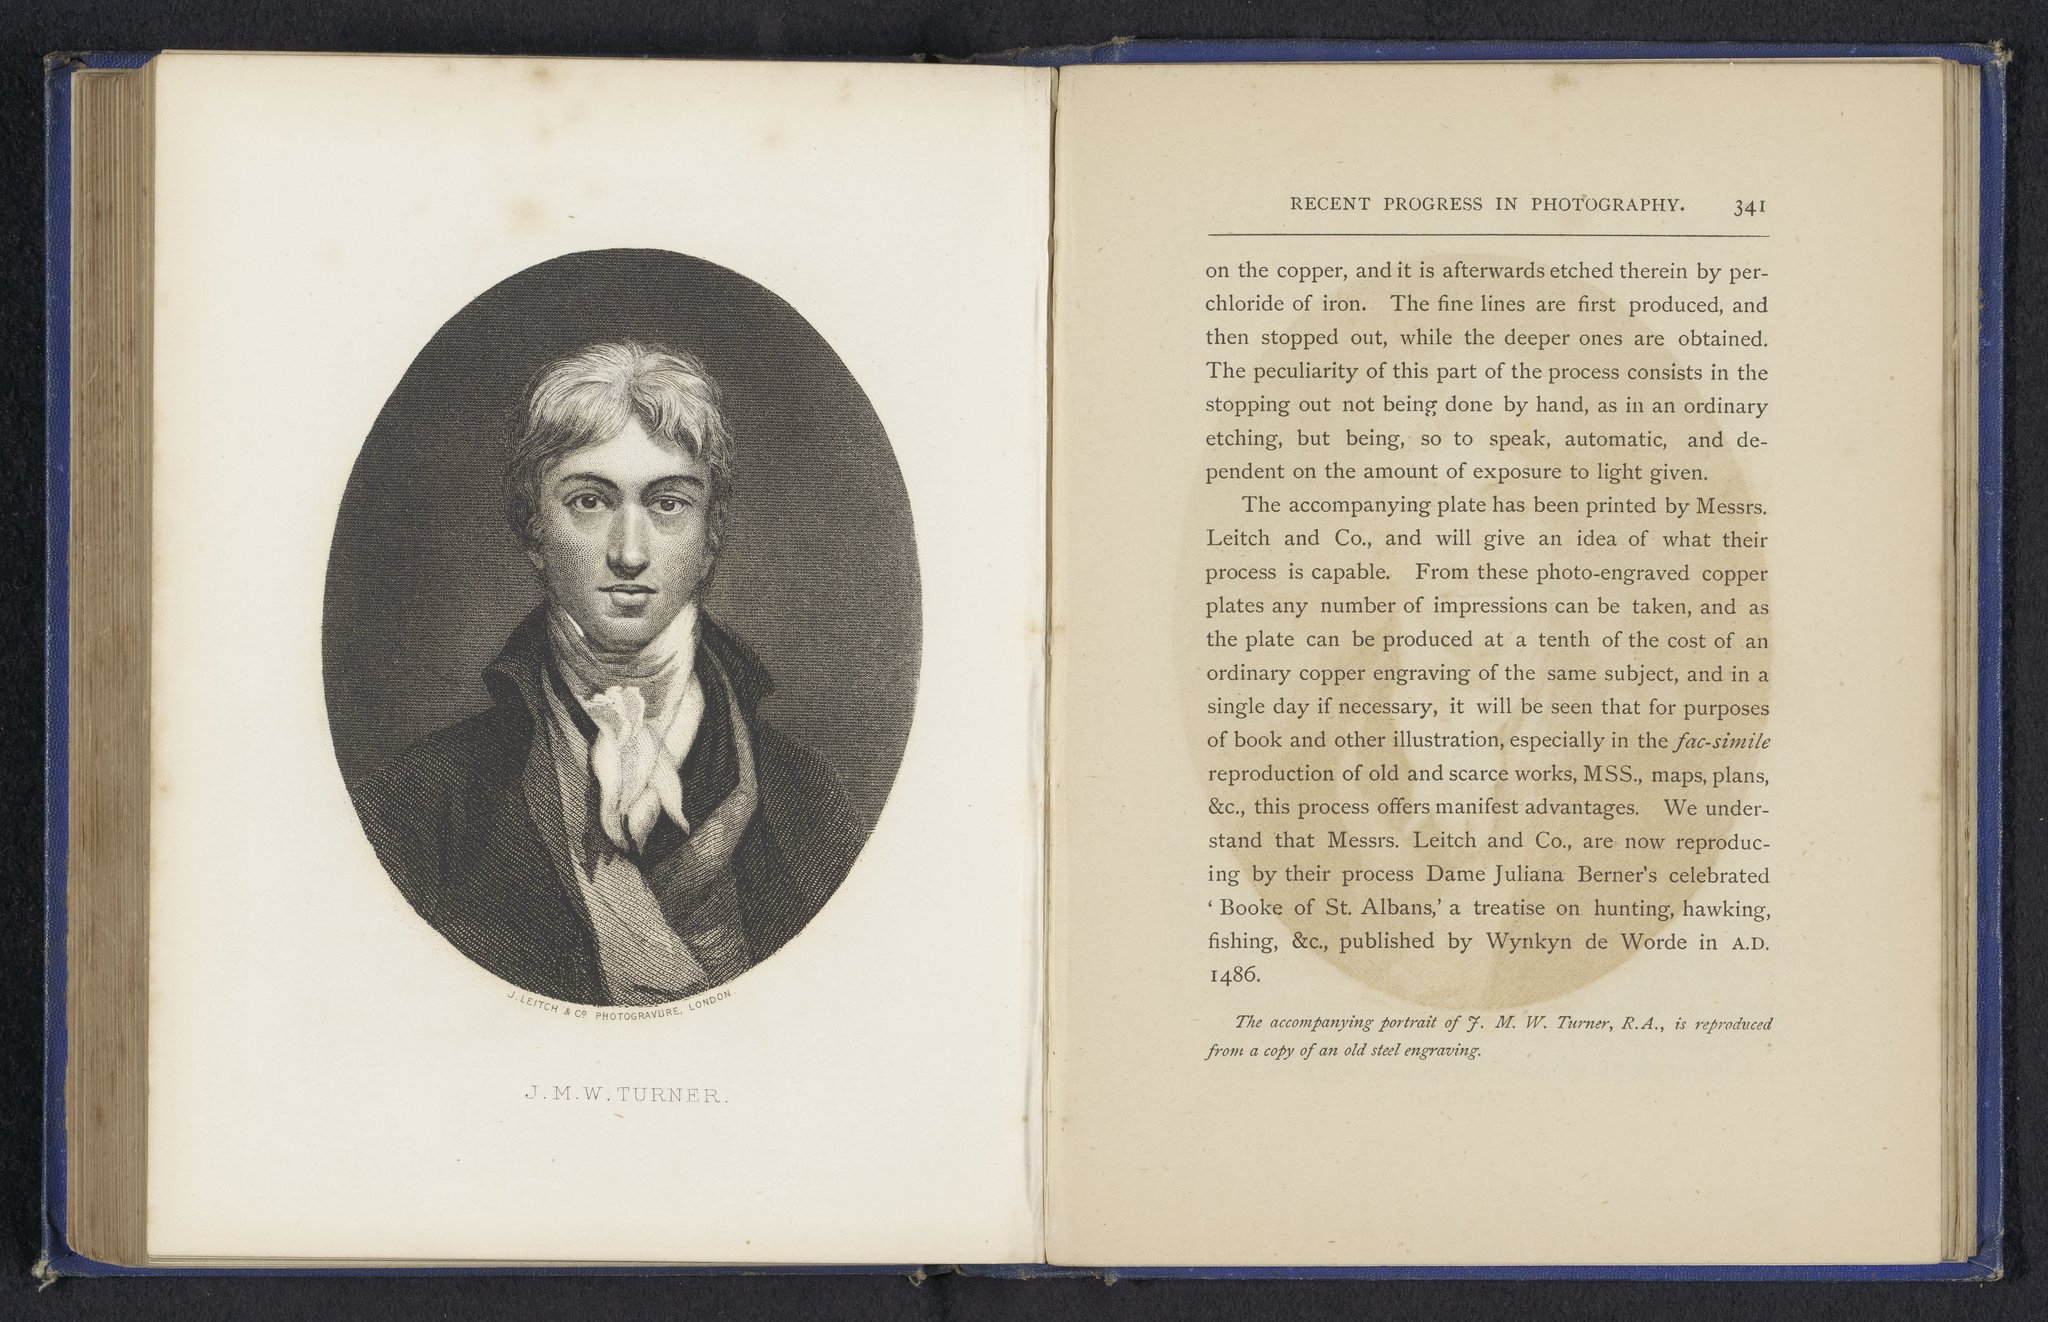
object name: photomechanical print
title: J.M.W. Turner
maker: Anonymous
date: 1868-1878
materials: paper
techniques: photoaquatint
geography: london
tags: london, print maker, draughtsman, joseph mallord william turner, portrait, self-portrait of artist